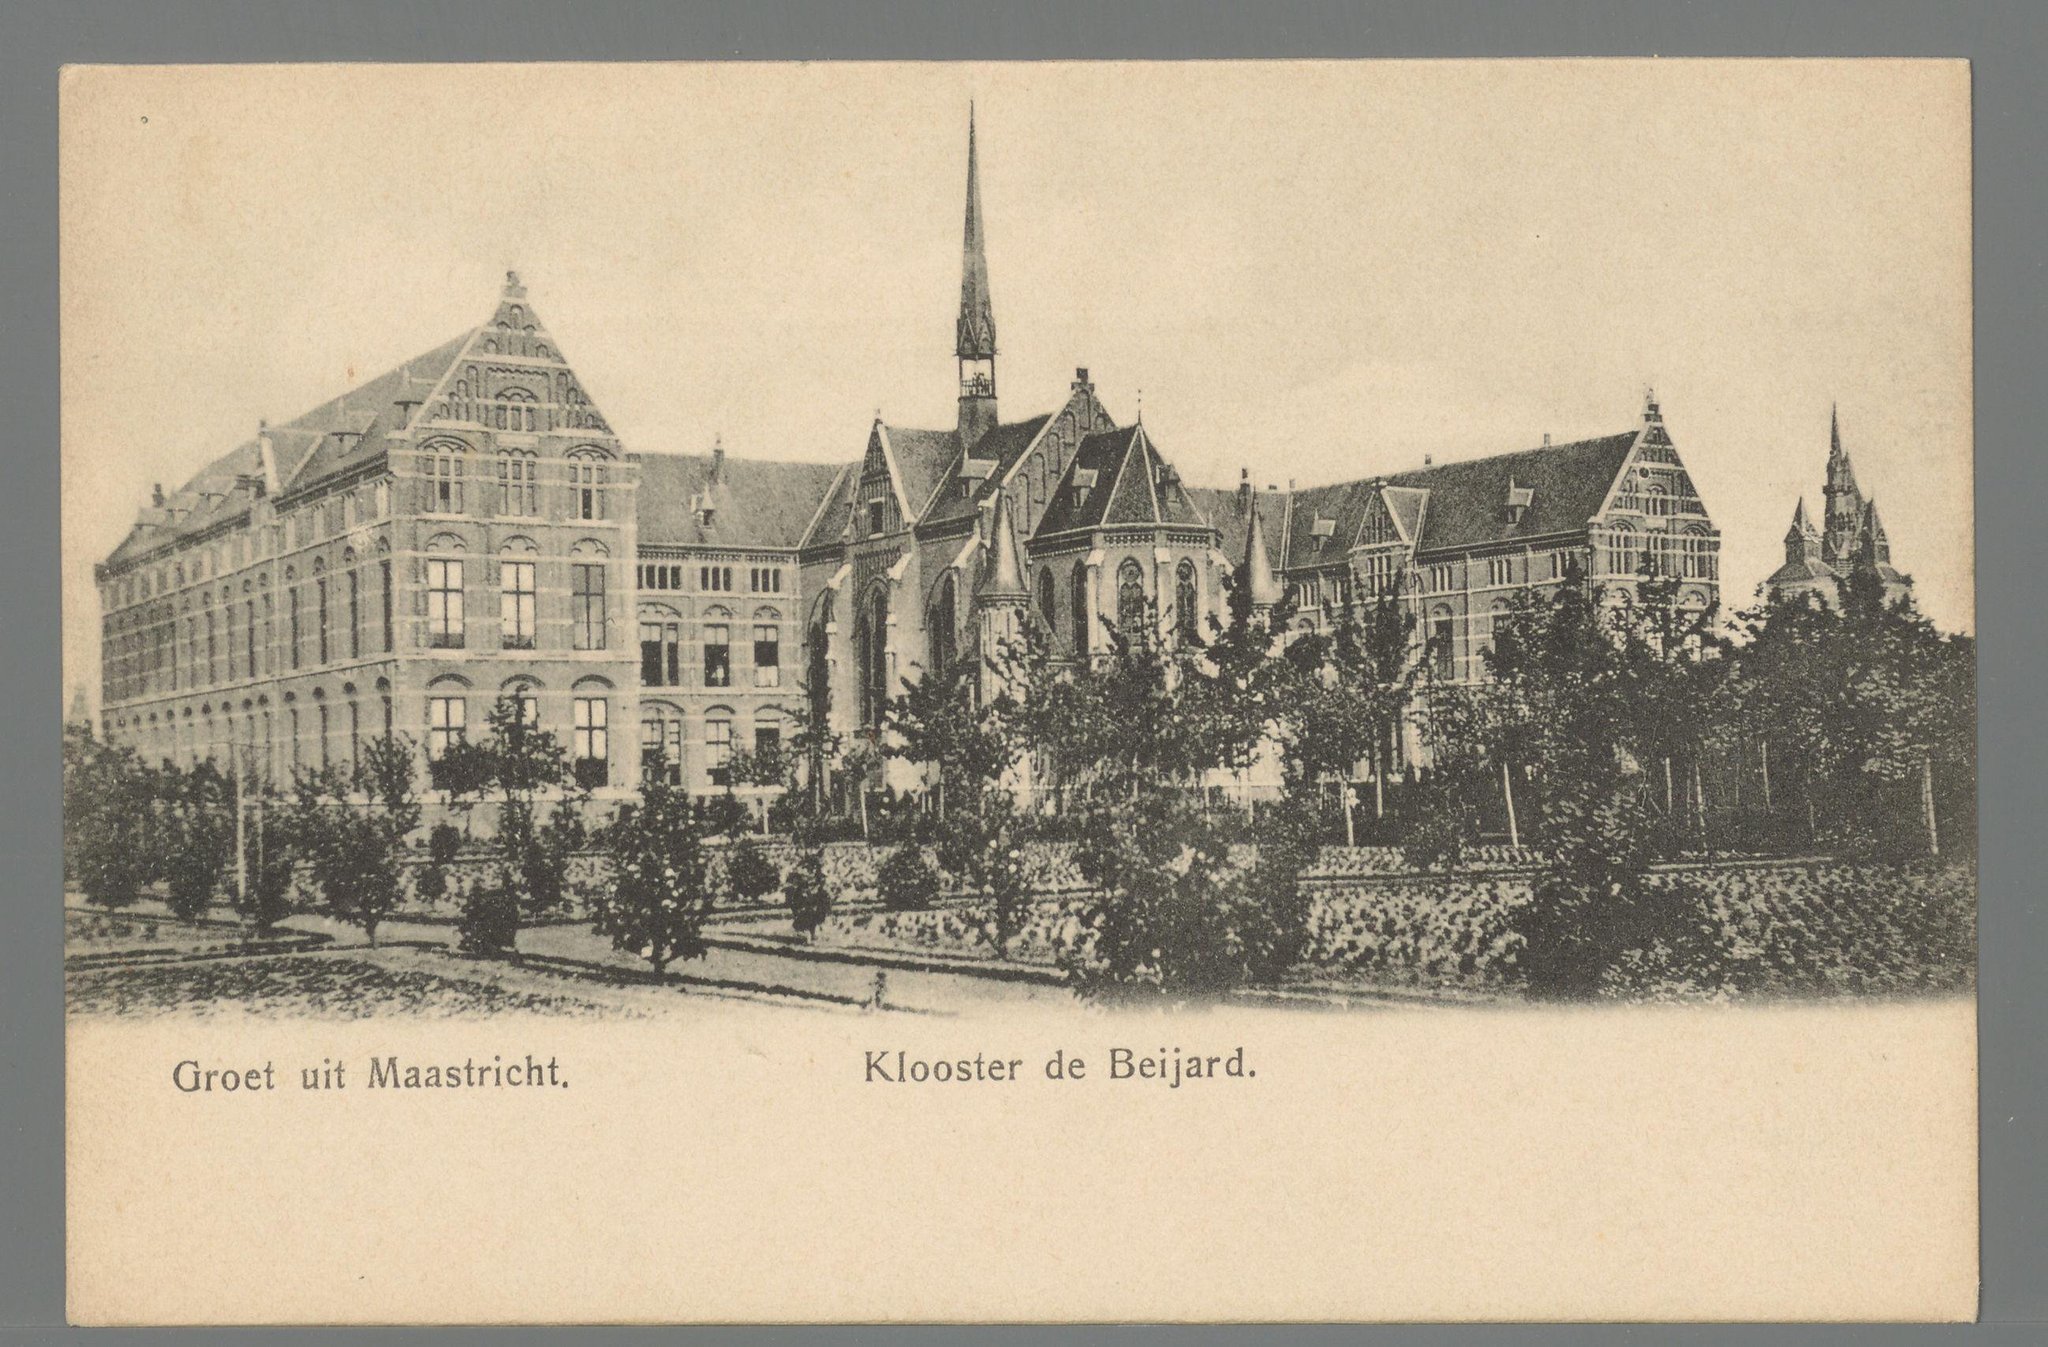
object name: ansichtkaart, prentbriefkaart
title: Groet uit Maastricht. Klooster de Beijard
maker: Anonymous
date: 1897-1905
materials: cardboard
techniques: photograph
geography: maastricht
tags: abbey, monastery, convent ~ roman catholic church